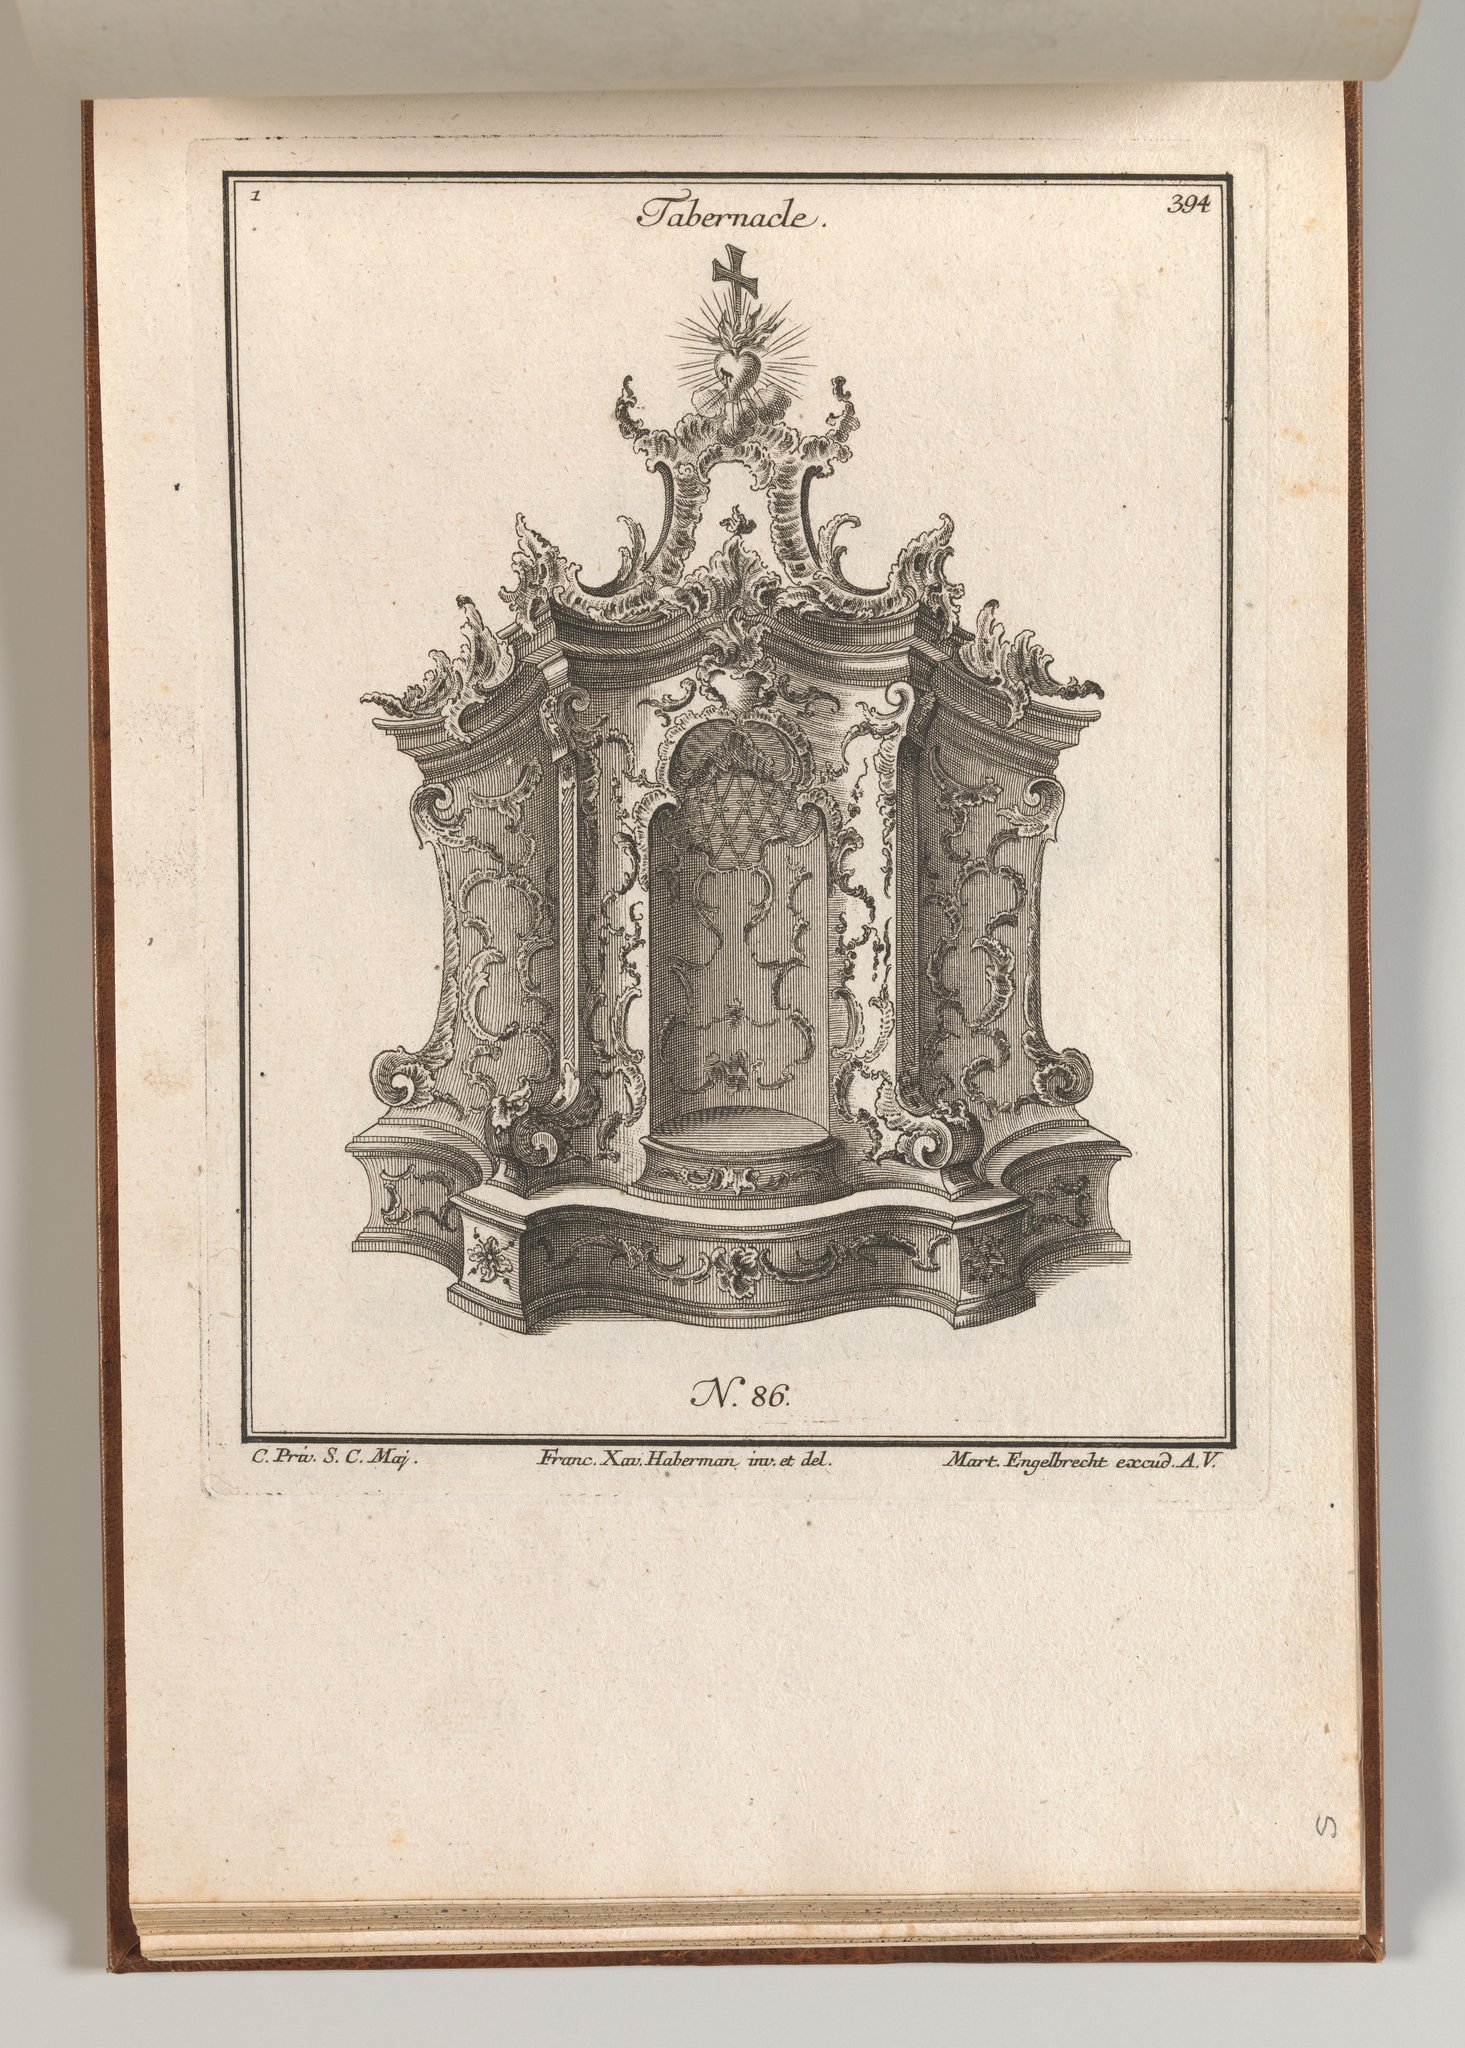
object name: album print ornament architecture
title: Design for a Tabernacle, Plate 1 from the series 'Tabernacle'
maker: franz xavier habermann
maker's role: artist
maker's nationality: german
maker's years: 1721-1796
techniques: etching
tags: tabernacles